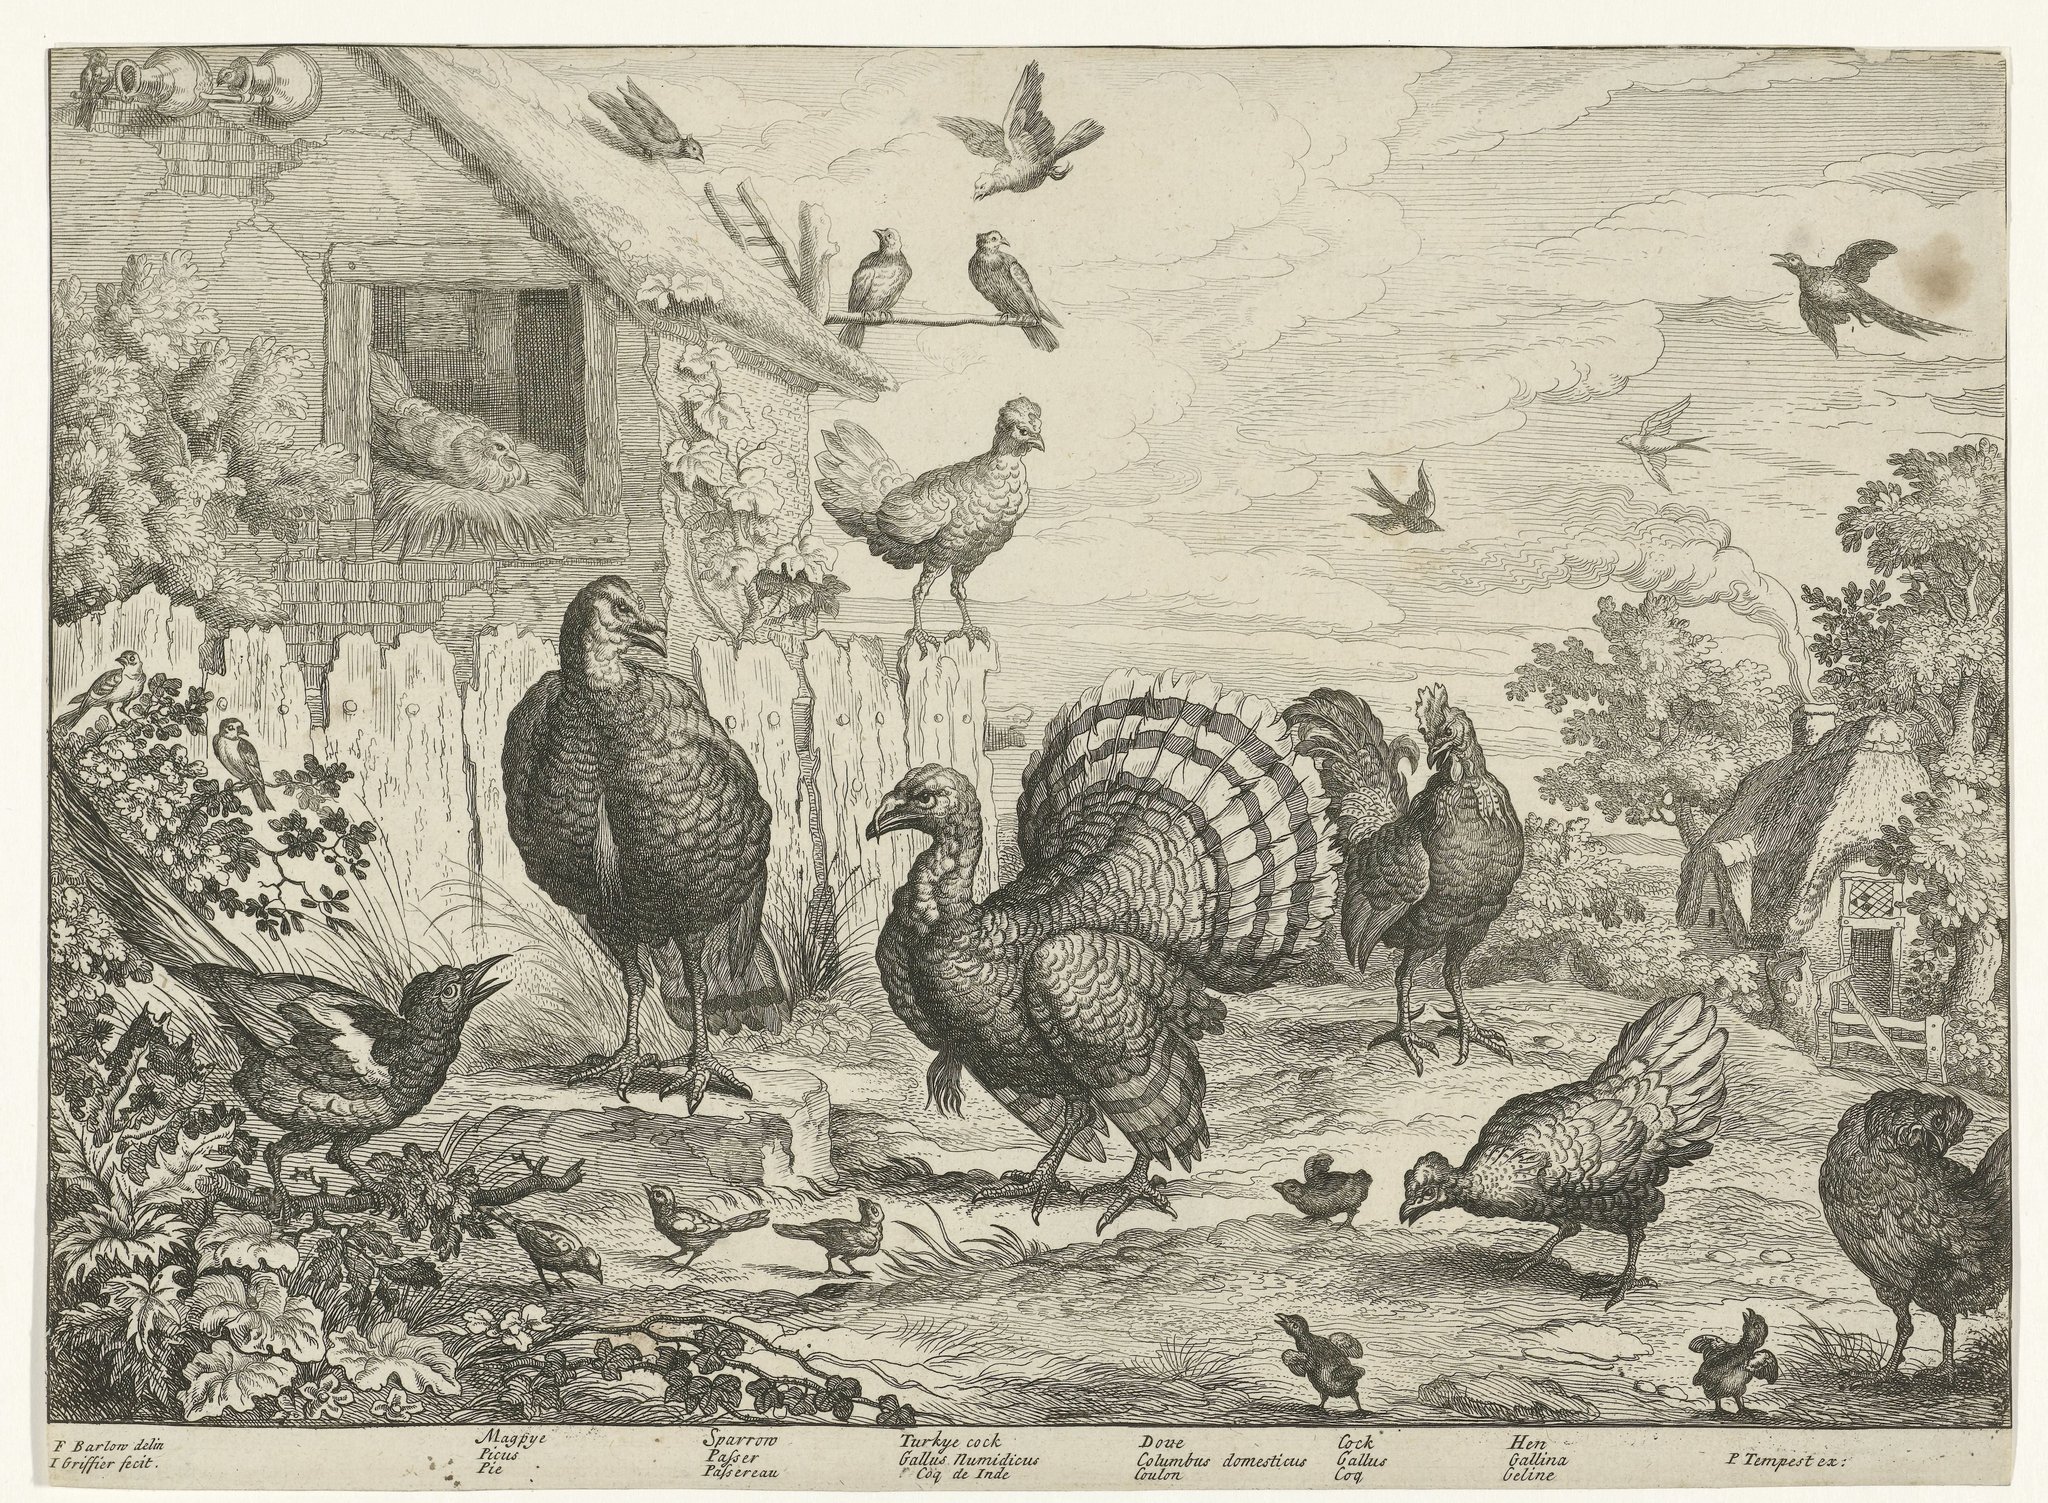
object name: print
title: Pluimvee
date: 1655-1718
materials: paper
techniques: engraving, etching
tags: birds, walker and runner birds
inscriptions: collector's mark: Lugt 2228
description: Pluimvee bij een boerenhuis en een duiventil. Op de voorgrond zijn een kalkoen, een aantal kippen, een haan en ander gevogelte afgebeeld. In de marge staan de namen van de vogels in het Engels, Latijn en Frans.